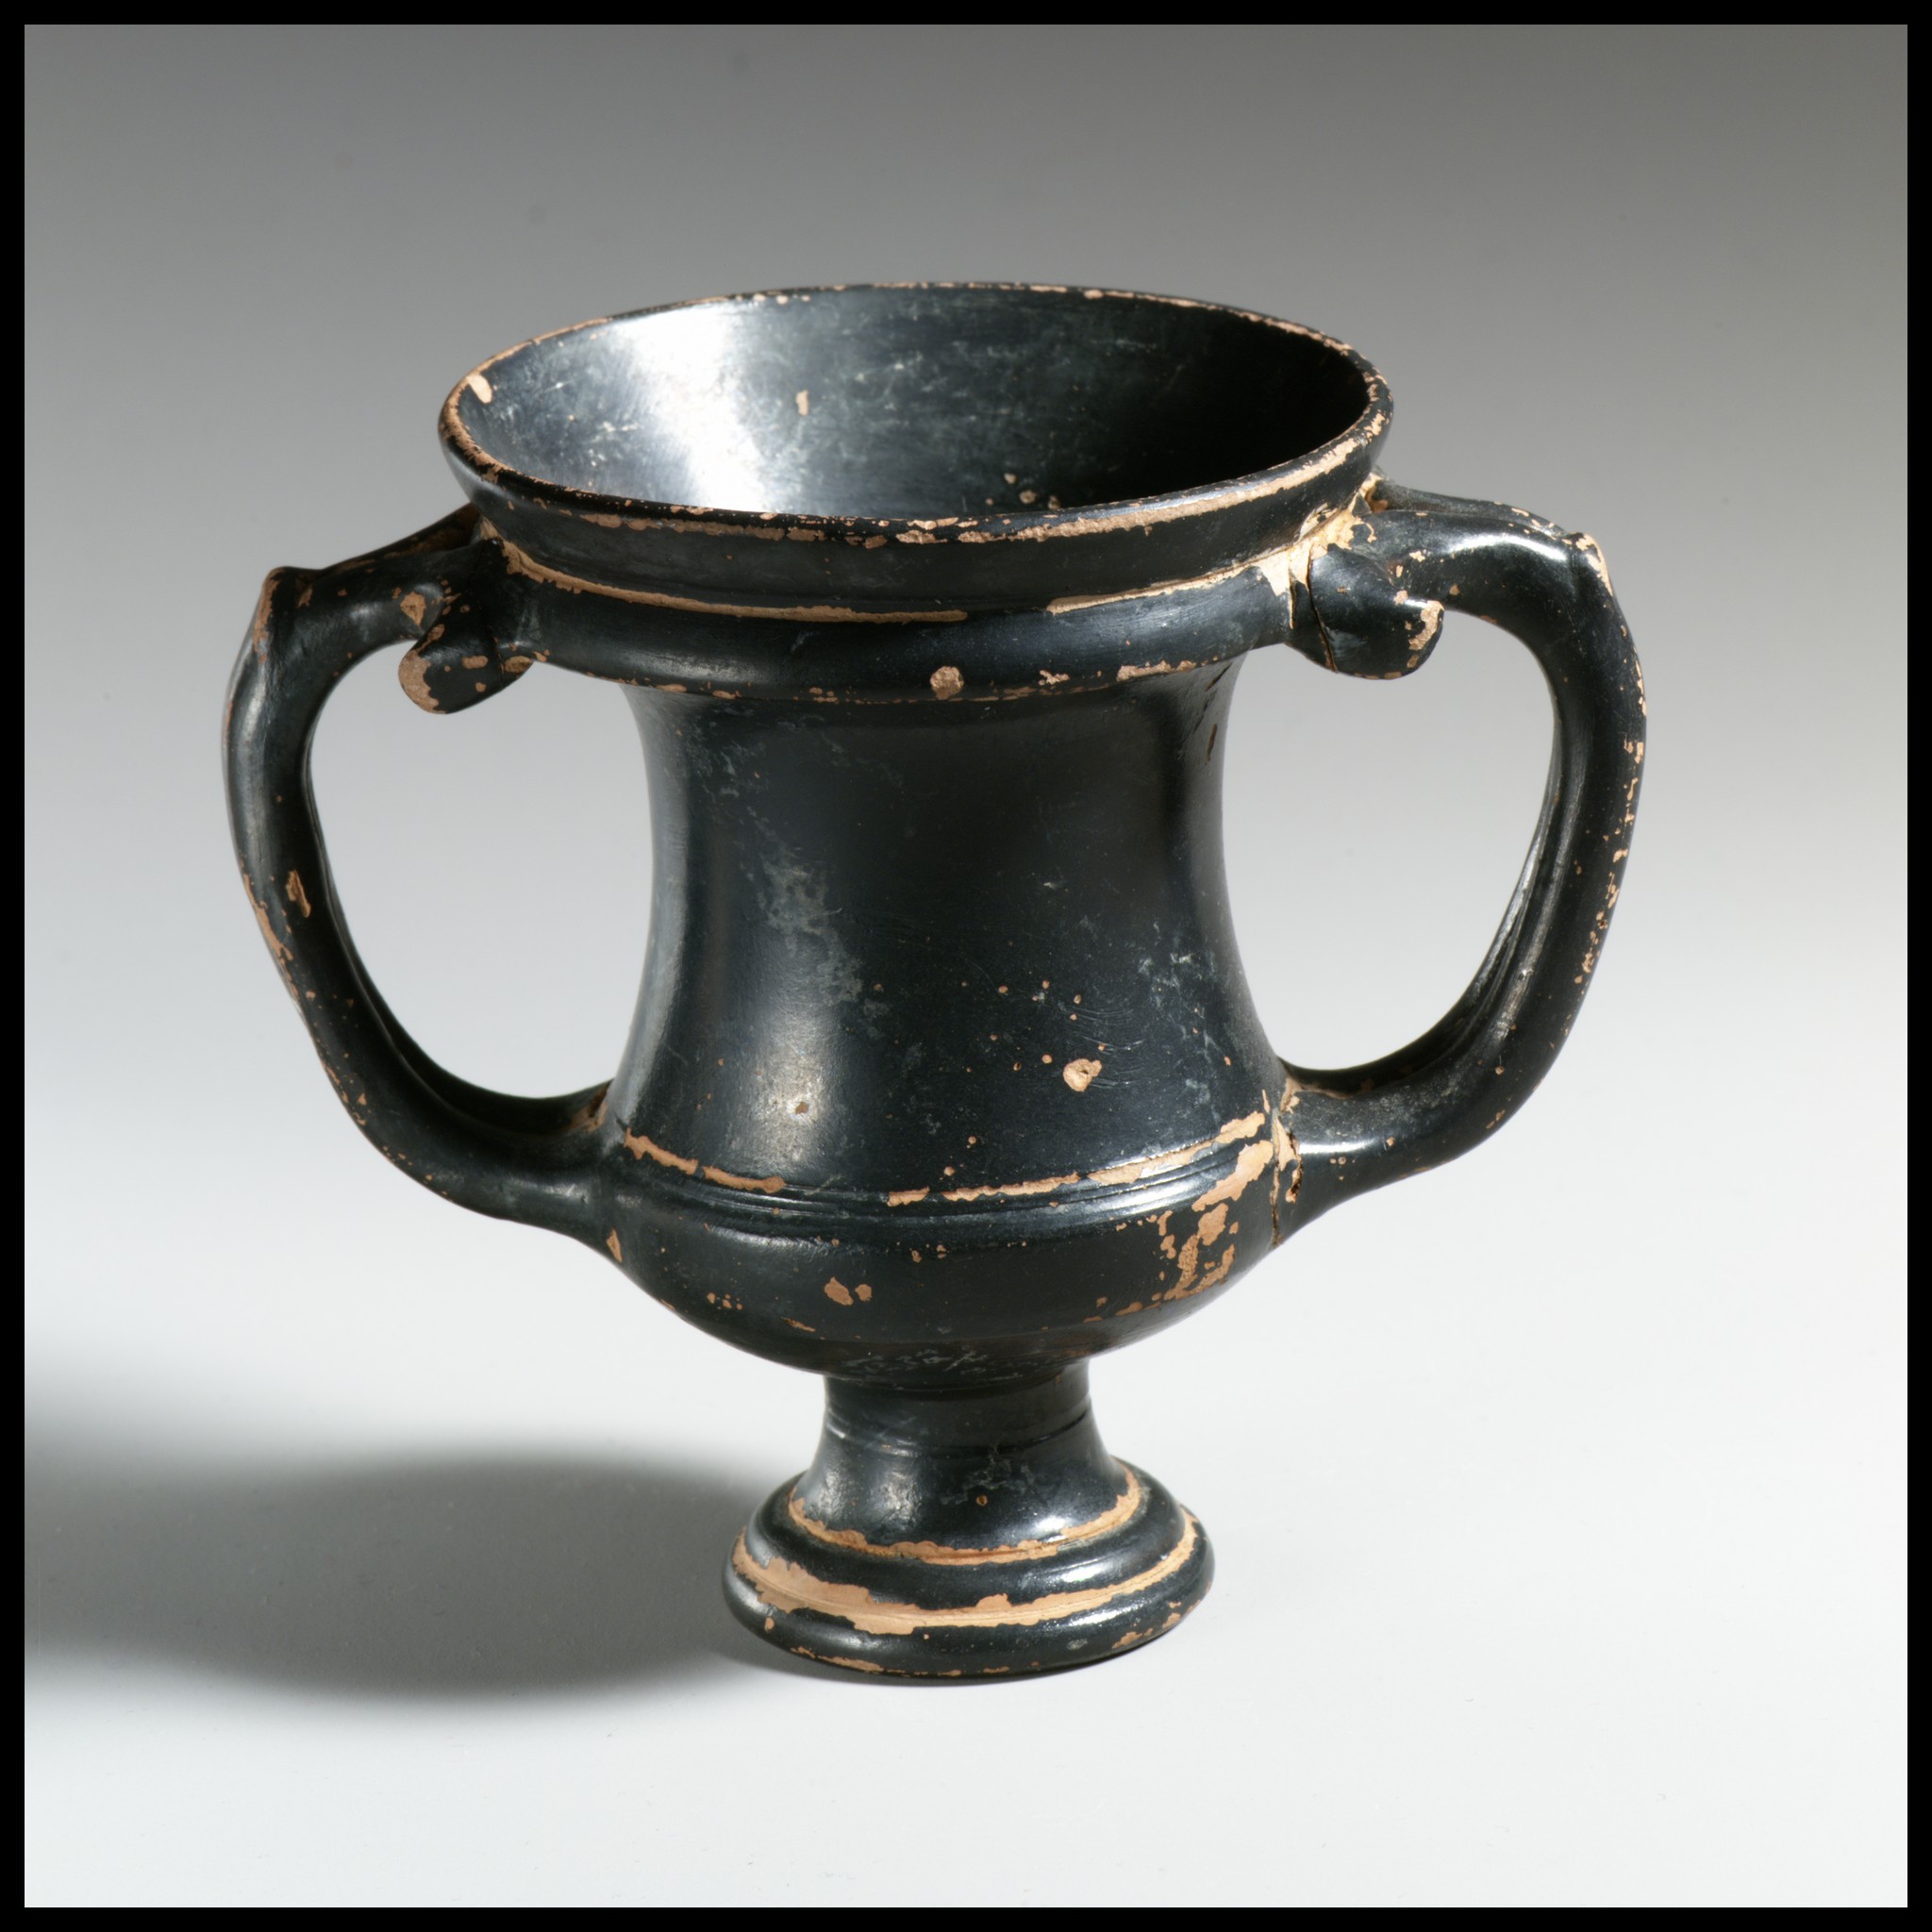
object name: kantharos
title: Terracotta kantharos (drinking cup)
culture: etruscan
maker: group of vatican g.116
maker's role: artist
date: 300-201 BCE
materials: terracotta